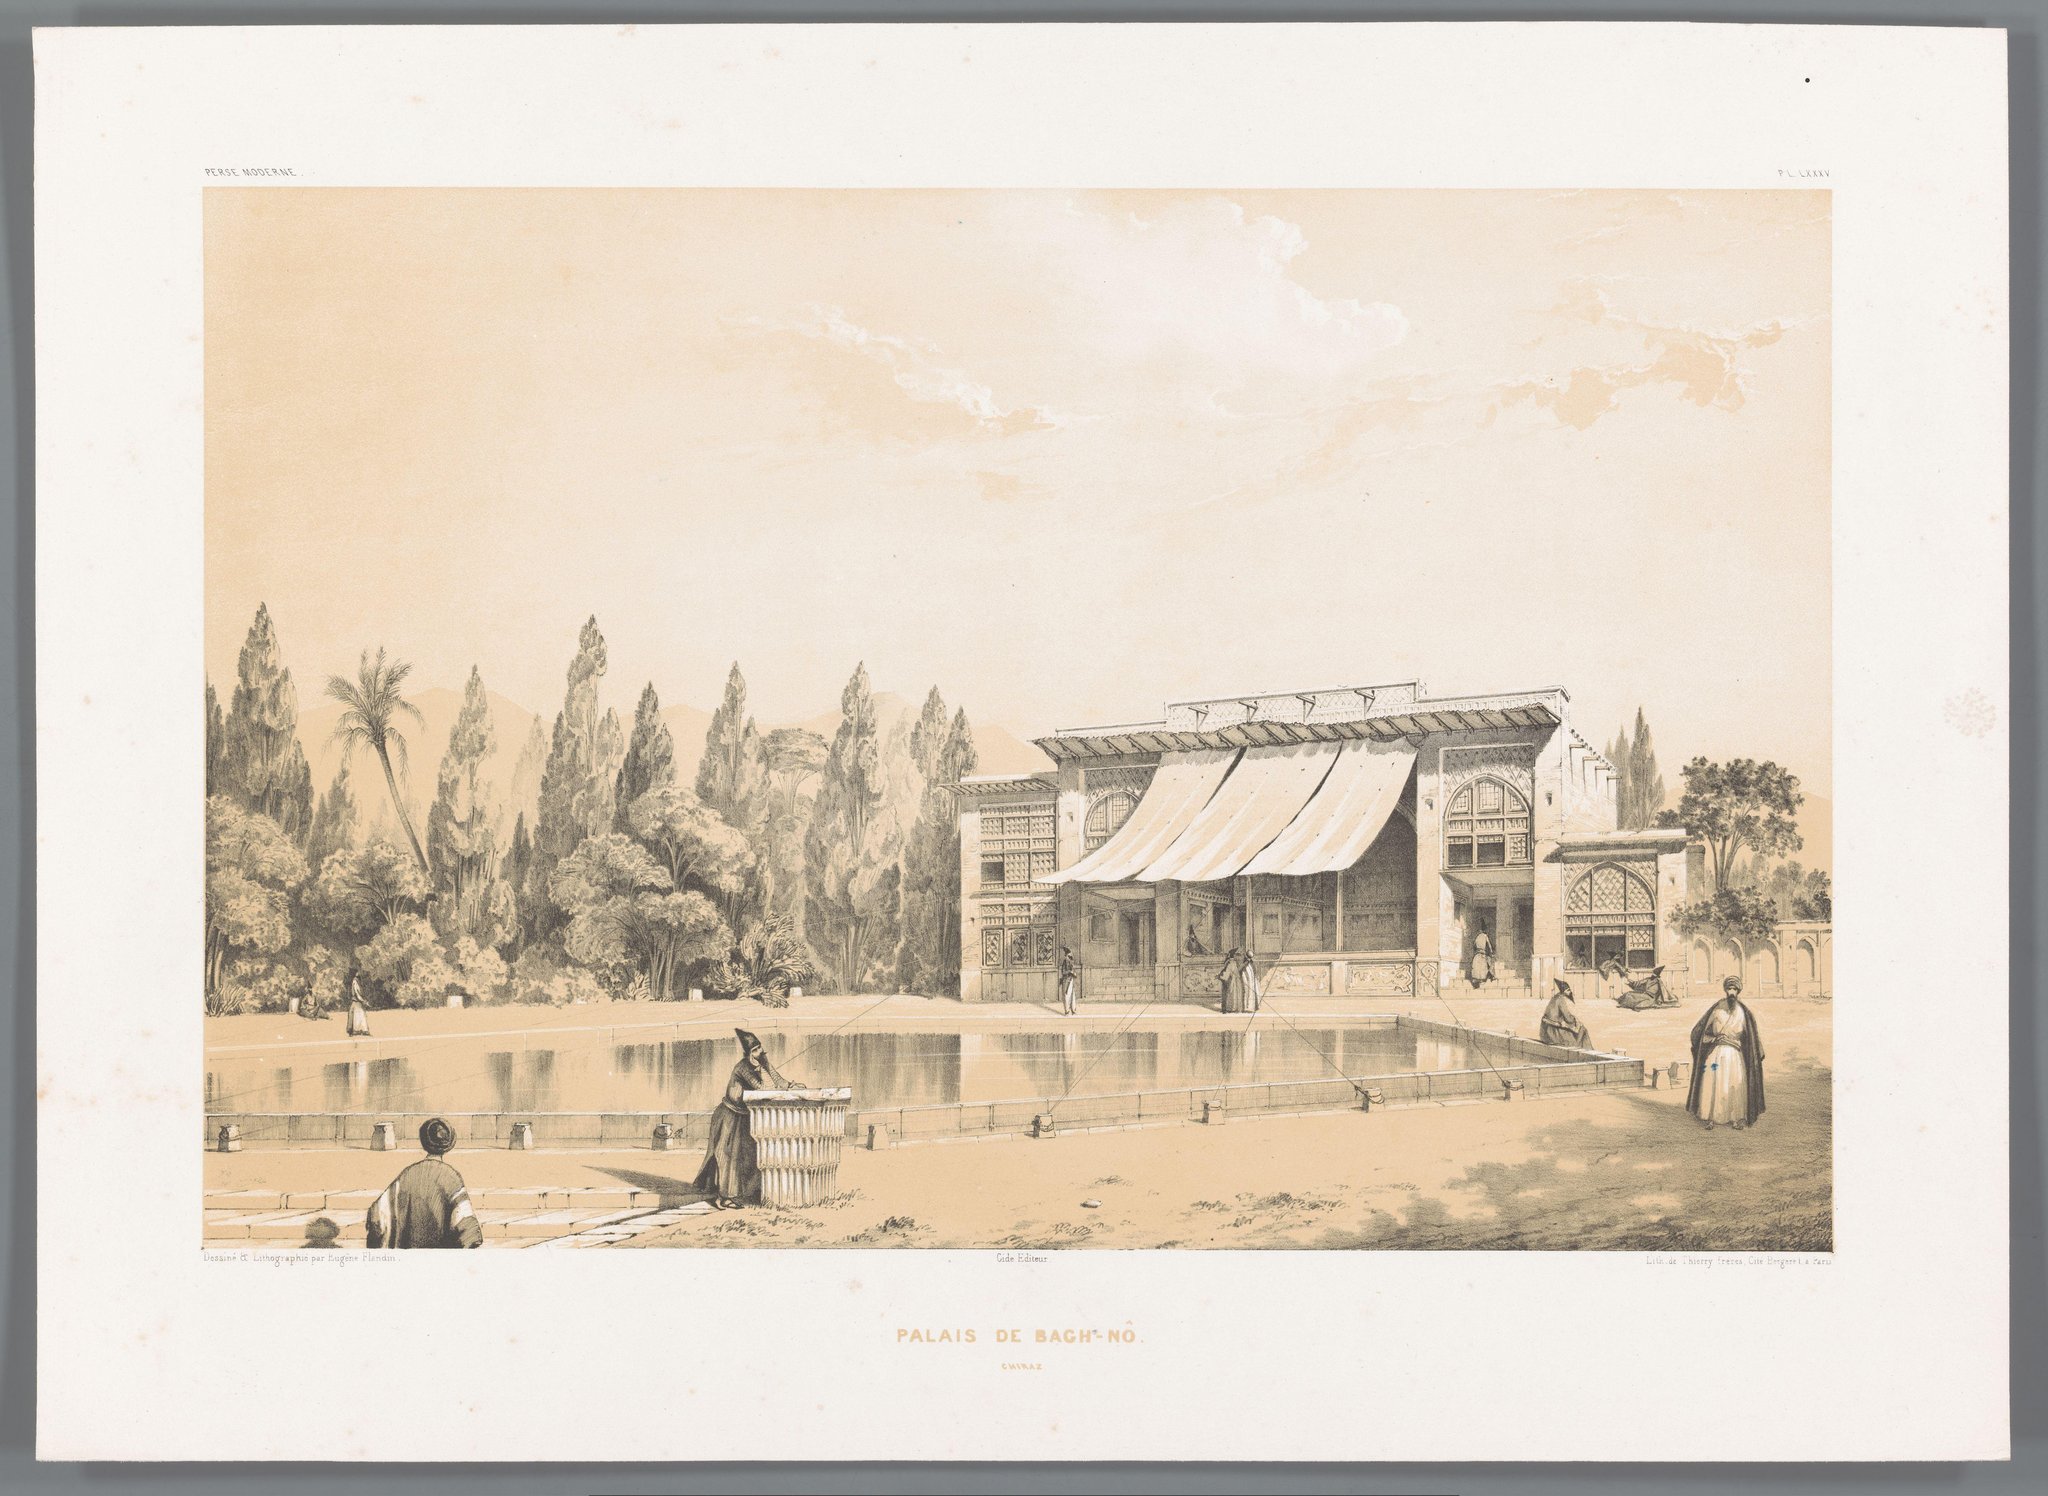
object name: print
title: Perse moderne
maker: eugène flandin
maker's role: painter, print maker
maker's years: 1809-1889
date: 1843-1854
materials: paper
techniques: tone lithography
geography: paris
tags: palace, garden pond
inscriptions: collector's mark: Lugt 2228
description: Prent uit: Coste, Pascal-Xavier en Eugène Napoléon Flandin. Voyage en Perse de mm. Eugène Flandin, peintre, et Pascal Coste, architecte (...). 8 dln. Parijs: Gide et Jules Baudry, 1843-1854.